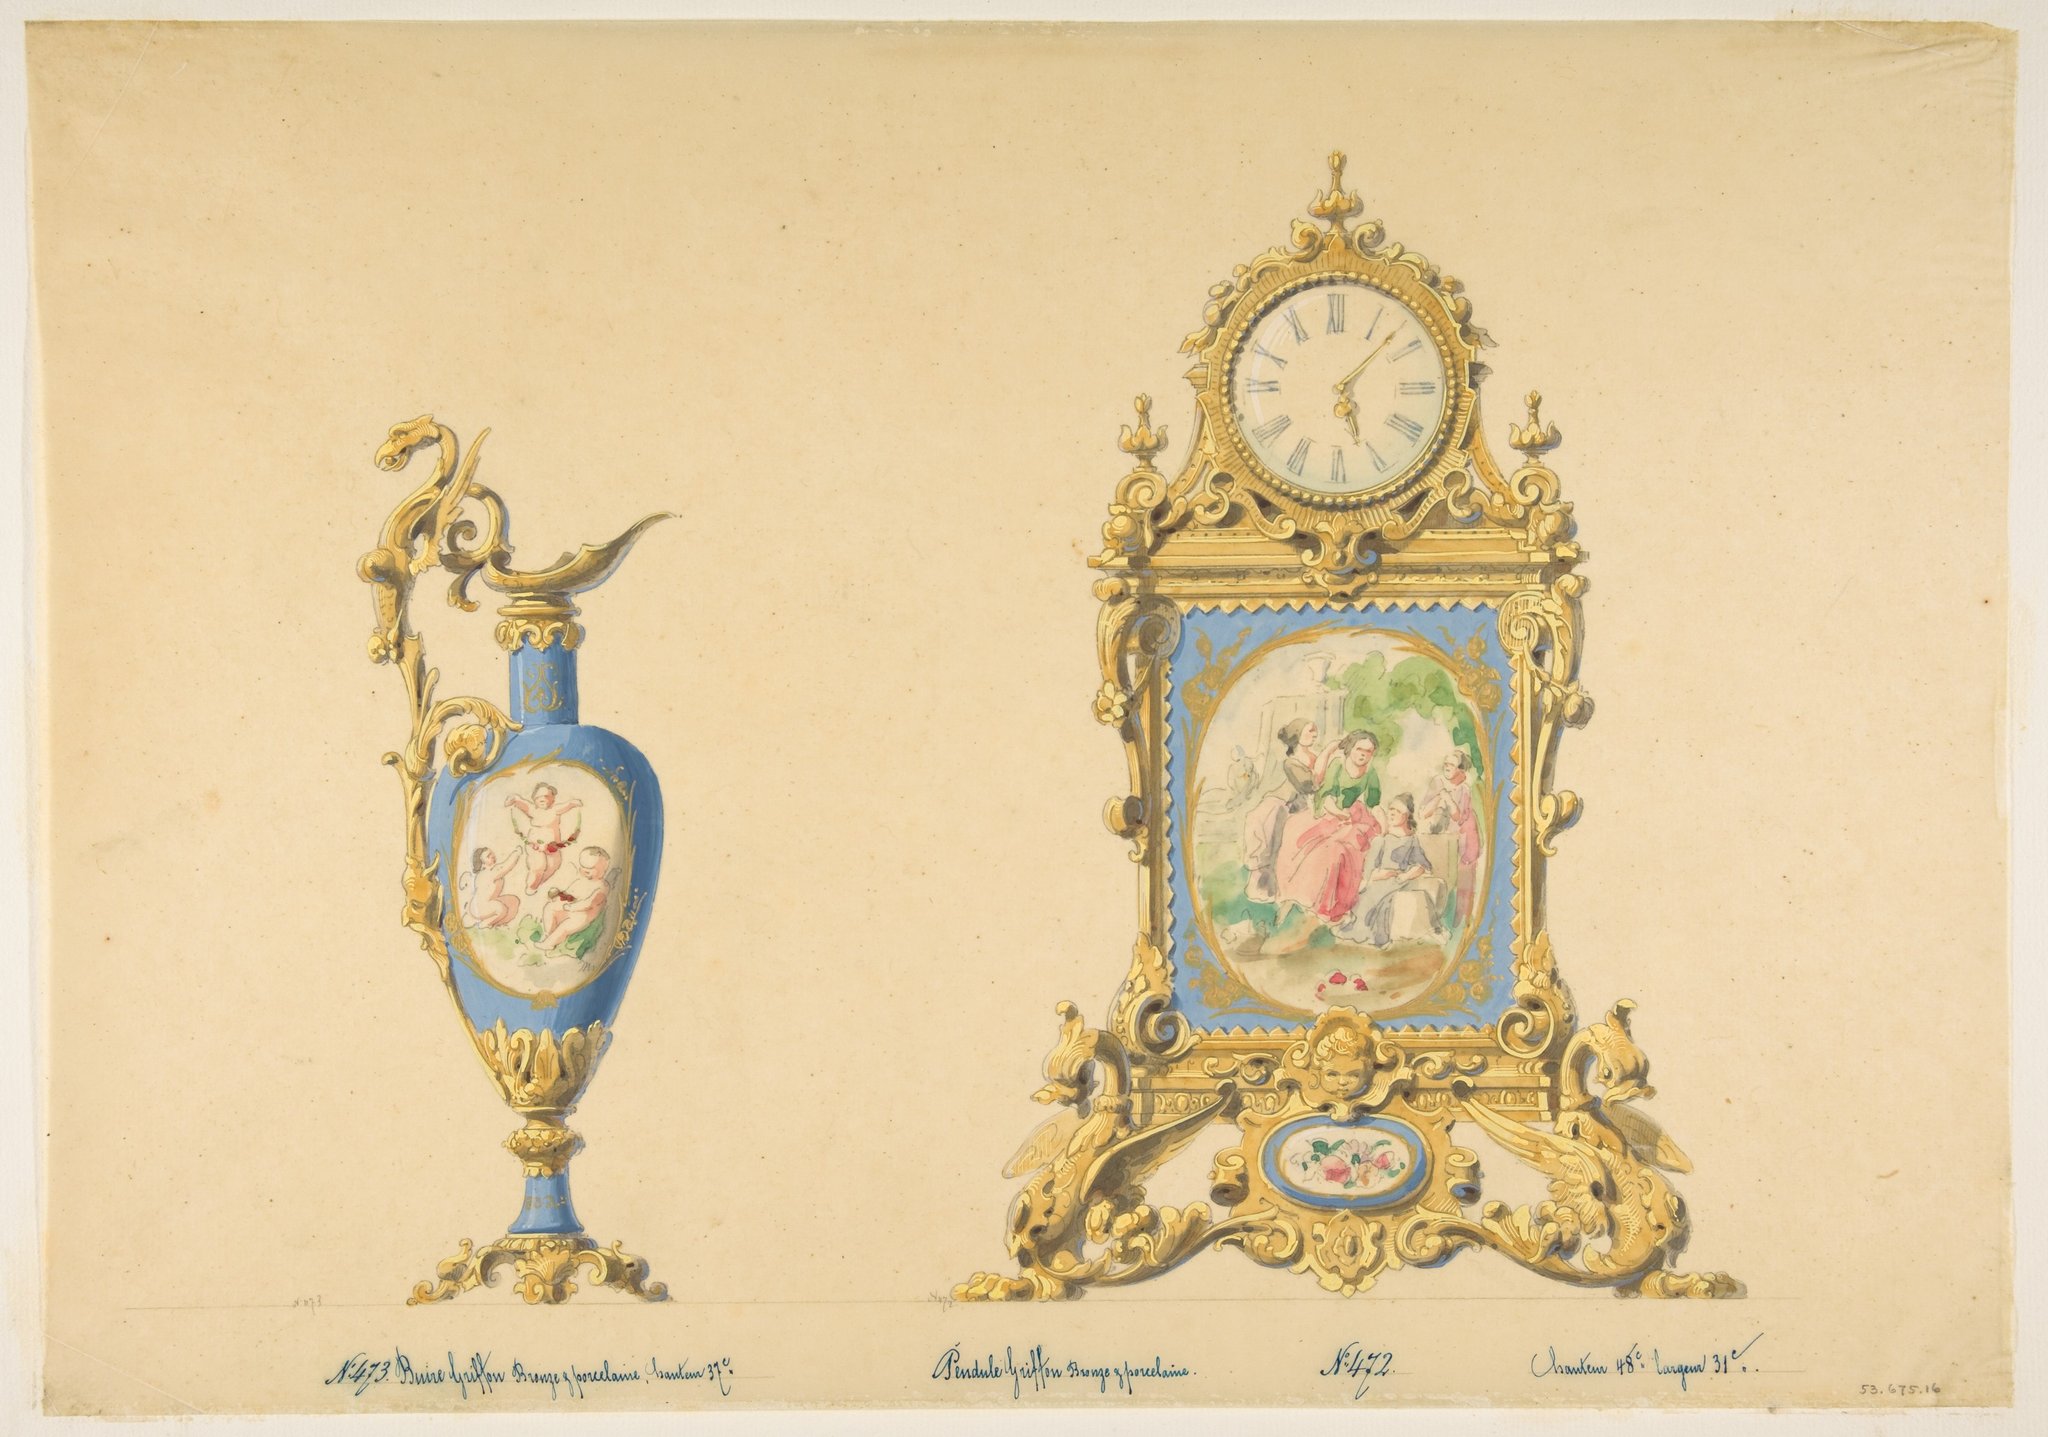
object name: drawing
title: Designs for an Ewer and Clock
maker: anonymous, french, 19th century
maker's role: artist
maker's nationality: french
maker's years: 1800-1900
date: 1801-1900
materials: gouache, graphite, watercolor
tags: women,clocks,ewers